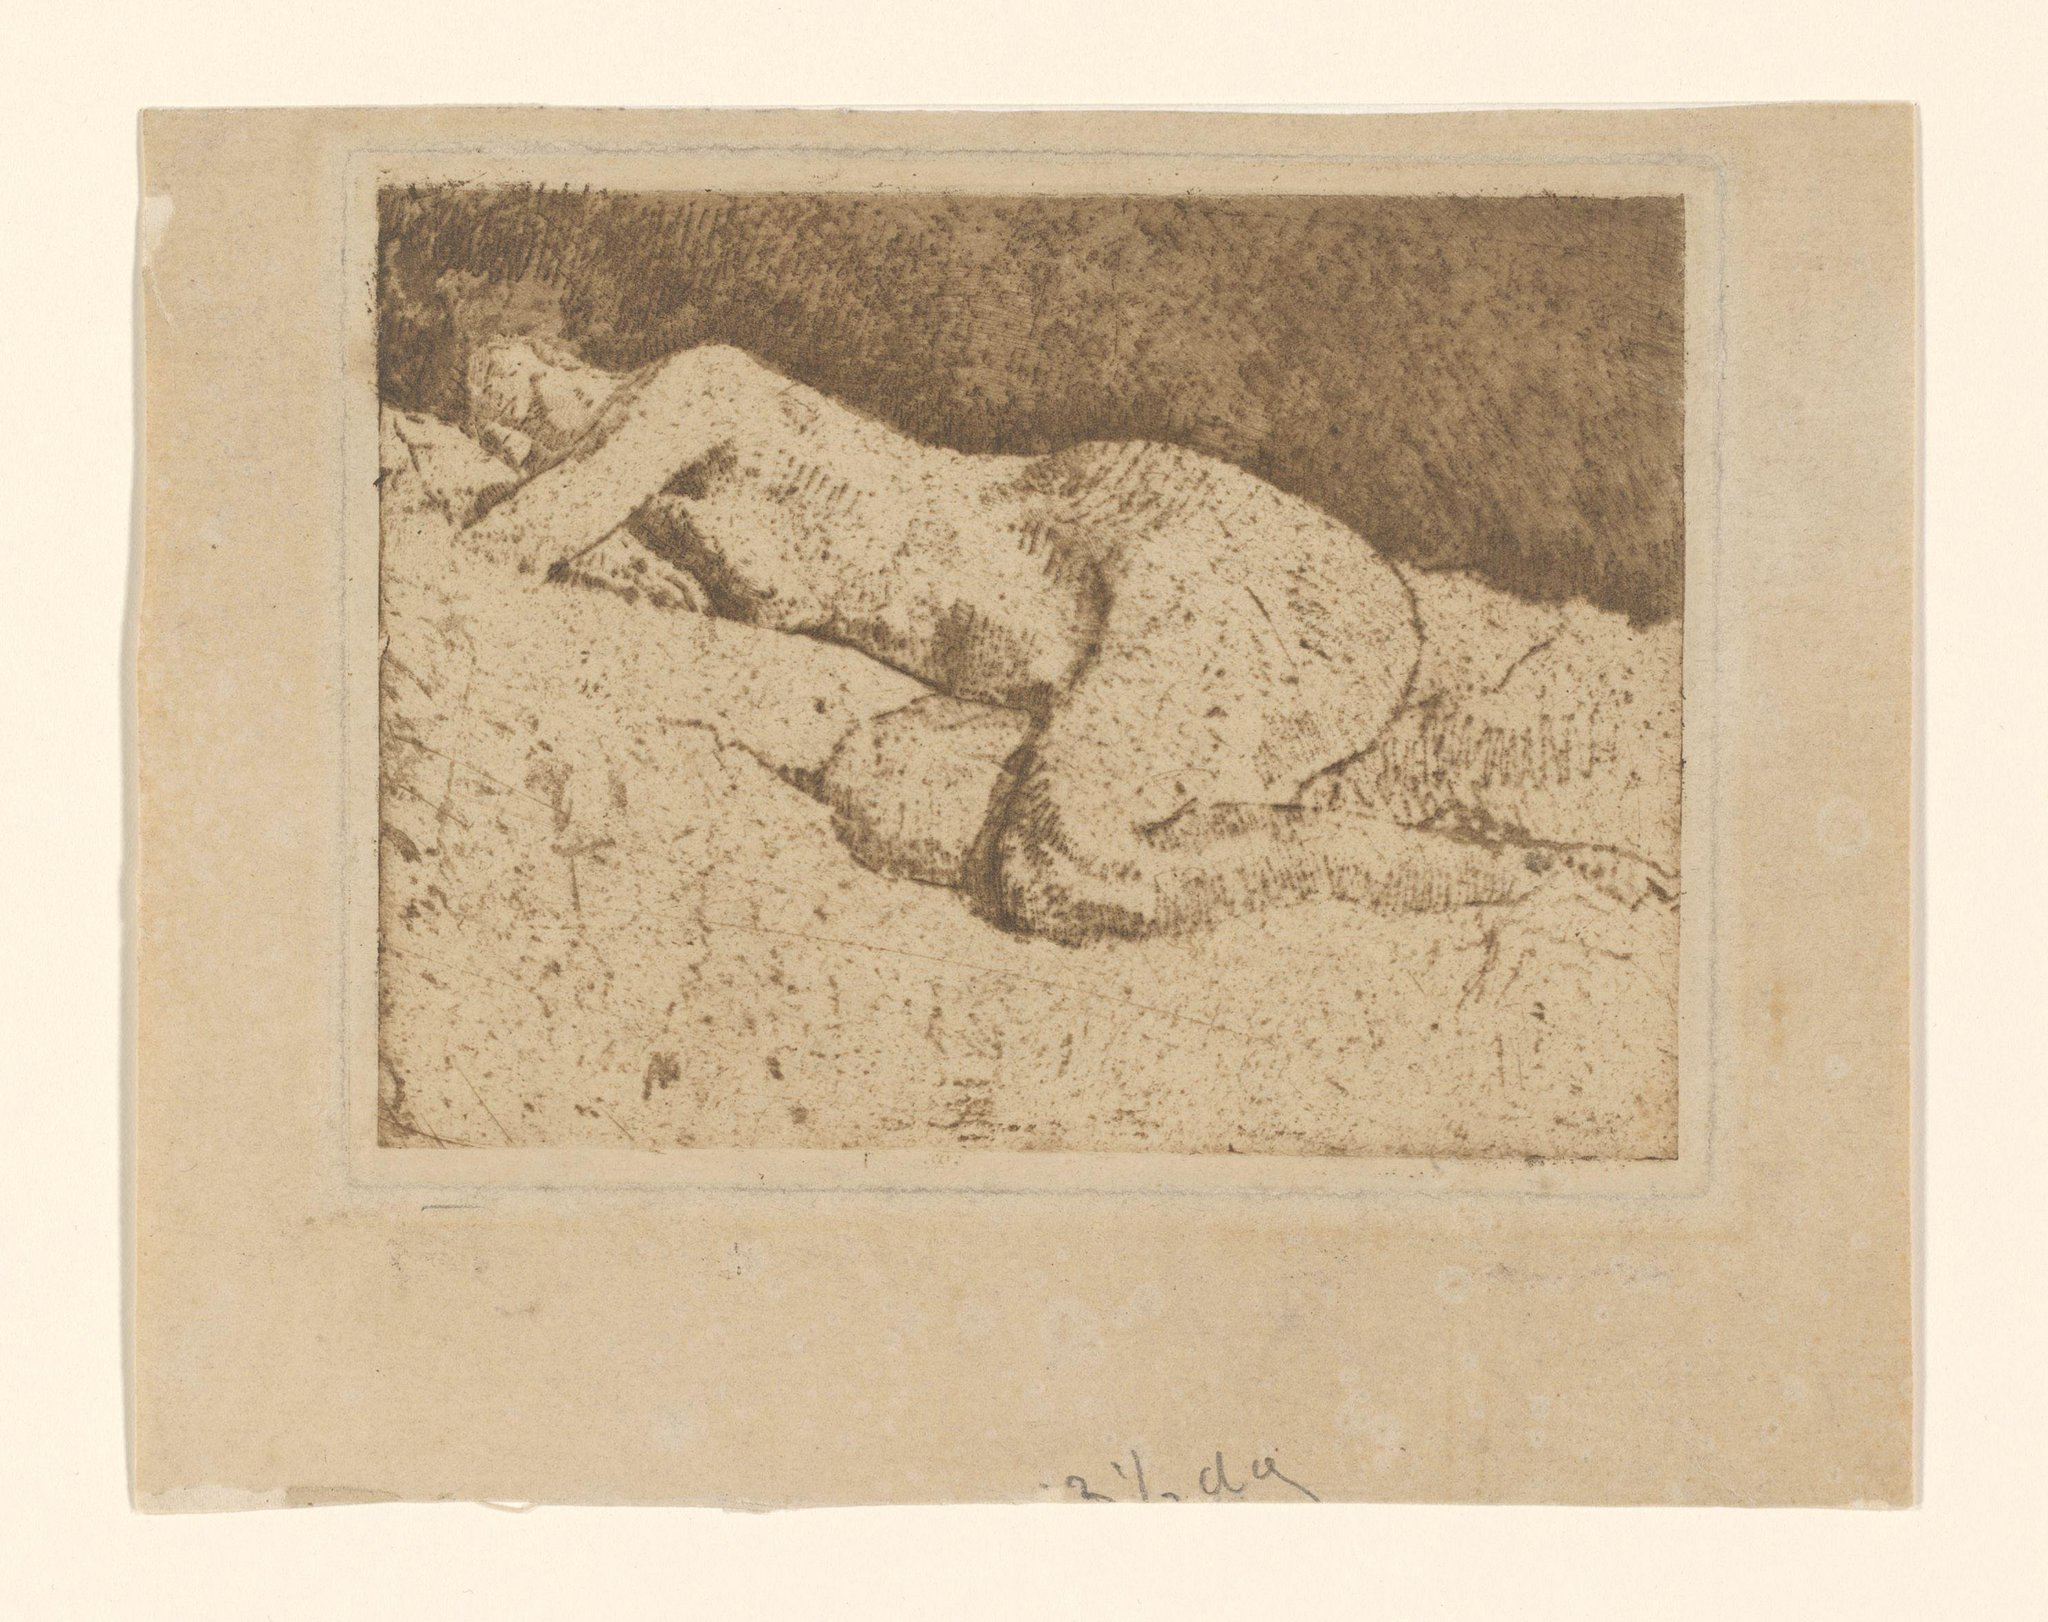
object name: print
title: Reclining Female Nude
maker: george hendrik breitner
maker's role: draughtsman, painter, print maker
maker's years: 1857-1923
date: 1891-1893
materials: paper, ink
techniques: aquatint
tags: woman (showing herself) undressed, quasi-nude, sleeping; unconsciousness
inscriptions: collector's mark: Lugt 2228, inscription: ‘[?]’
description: Naar 'Liggend naakt' van G.H. Breitner, olieverf op doek, Museum Boymans- Van Beuningen te Rotterdam.